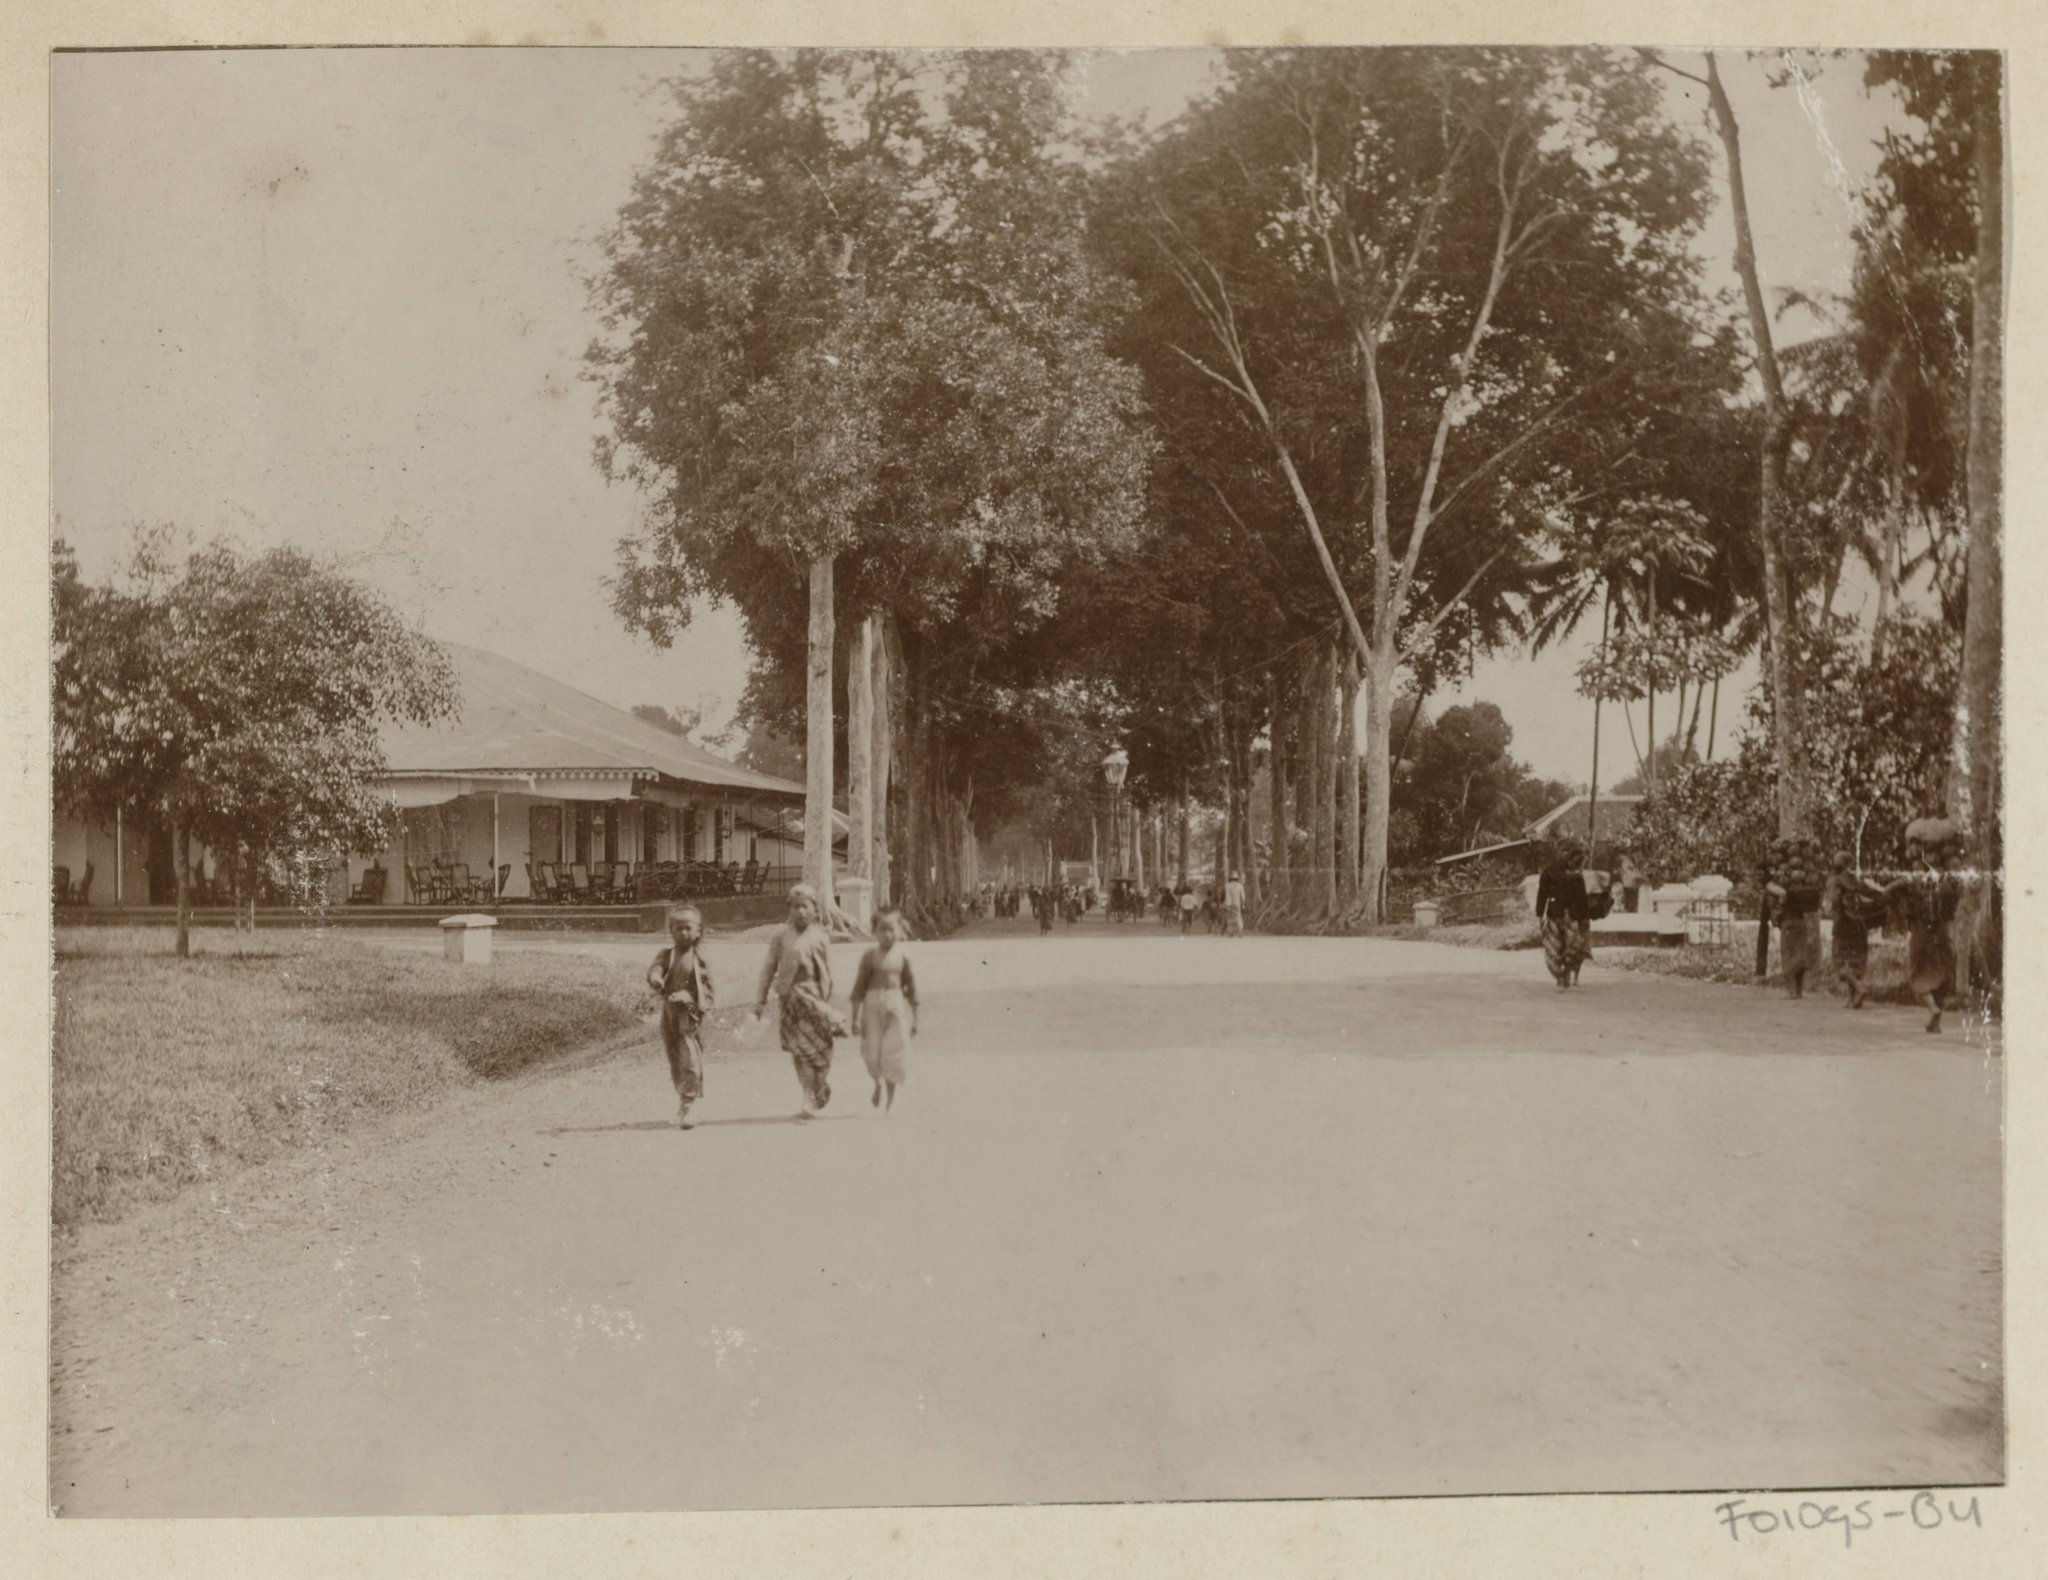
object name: photograph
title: Straatbeeld in Nederlands-Indië met kinderen, dragers en voorbijgangers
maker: Anonymous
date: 1895-1905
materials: paper, photographic support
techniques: collodion silver print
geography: dutch east indies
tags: street (+ city(-scape) with figures, staffage), dutch east indies, the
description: Onderdeel van Reisalbum met foto's van bezienswaardigheden in Italië, Zwitserland en Nederlands-Indië.